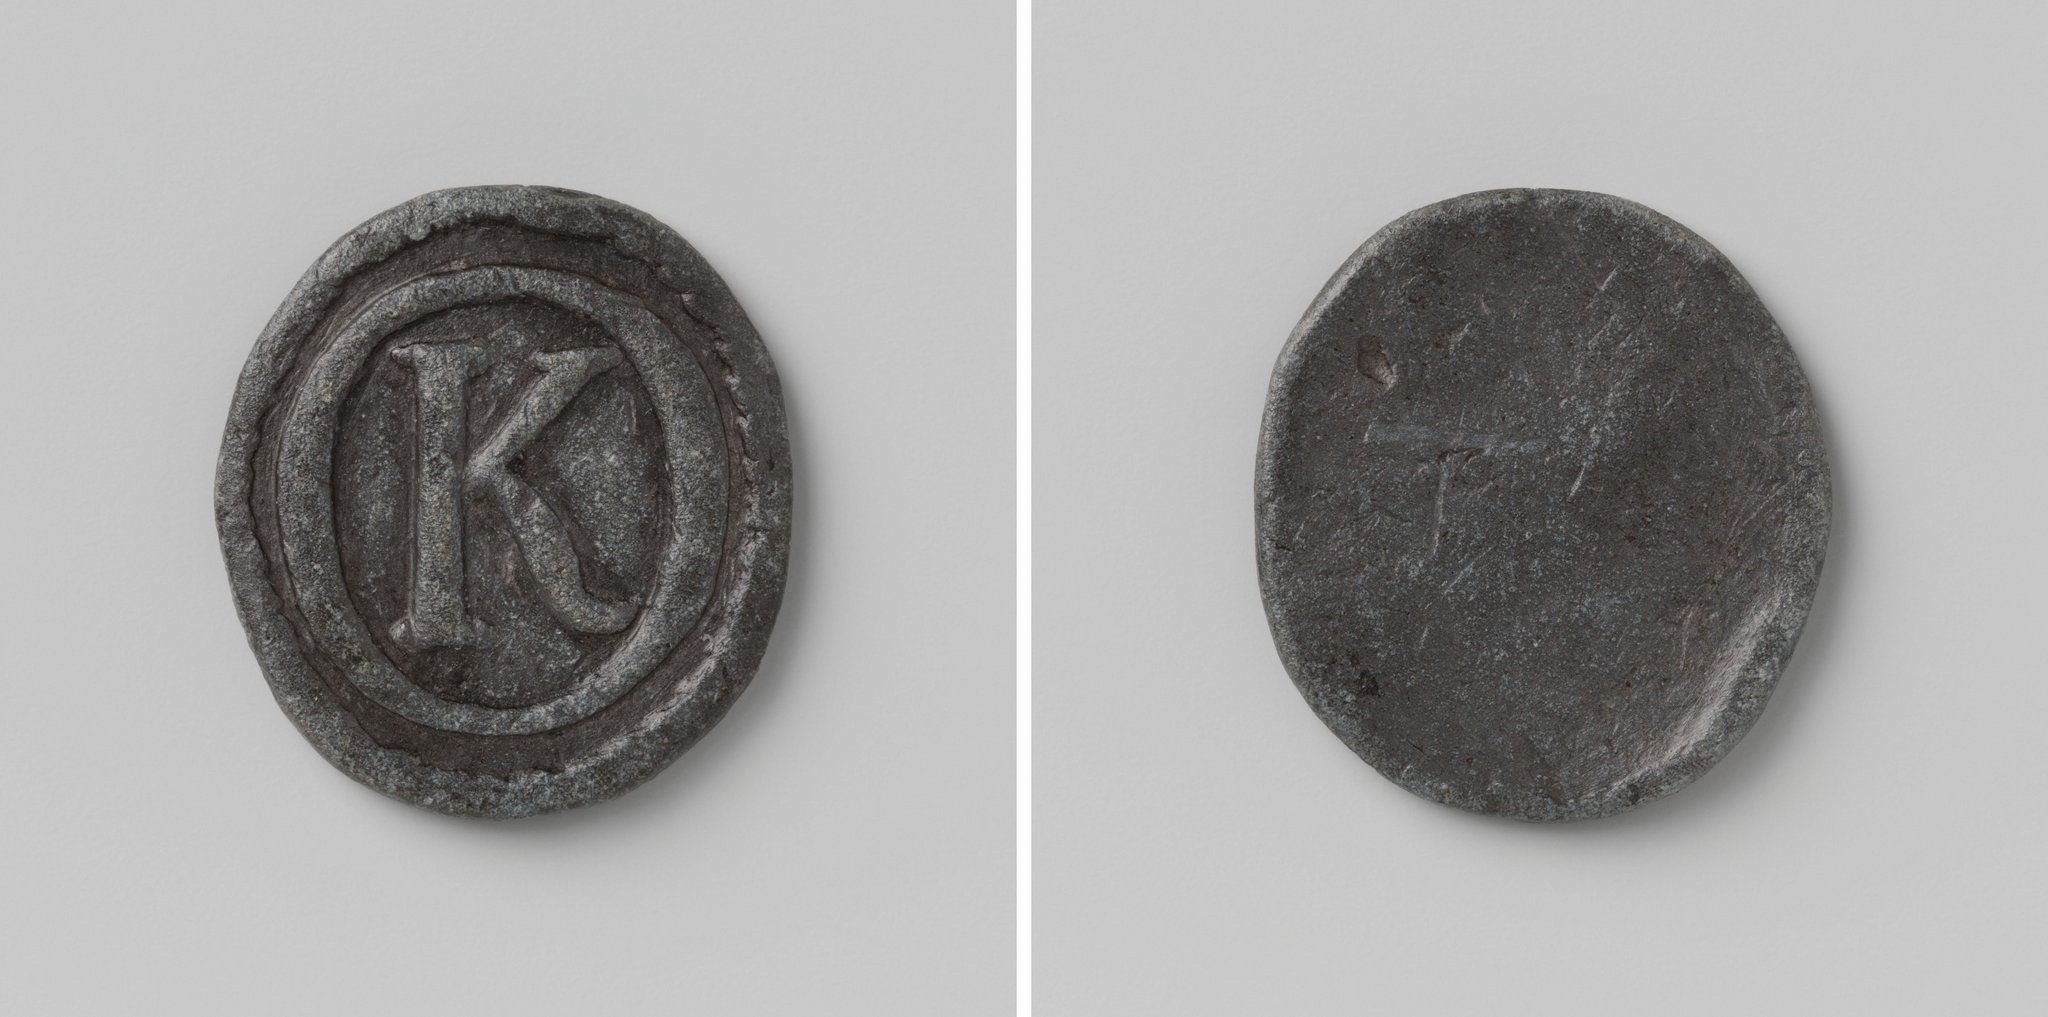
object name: medal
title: Penning met letter K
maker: Anonymous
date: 1650-1850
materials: lead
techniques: casting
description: Eenzijdige loden ovale penning. Voorzijde: letter K binnen cirkel en bladerkrans. Keerzijde: blanco